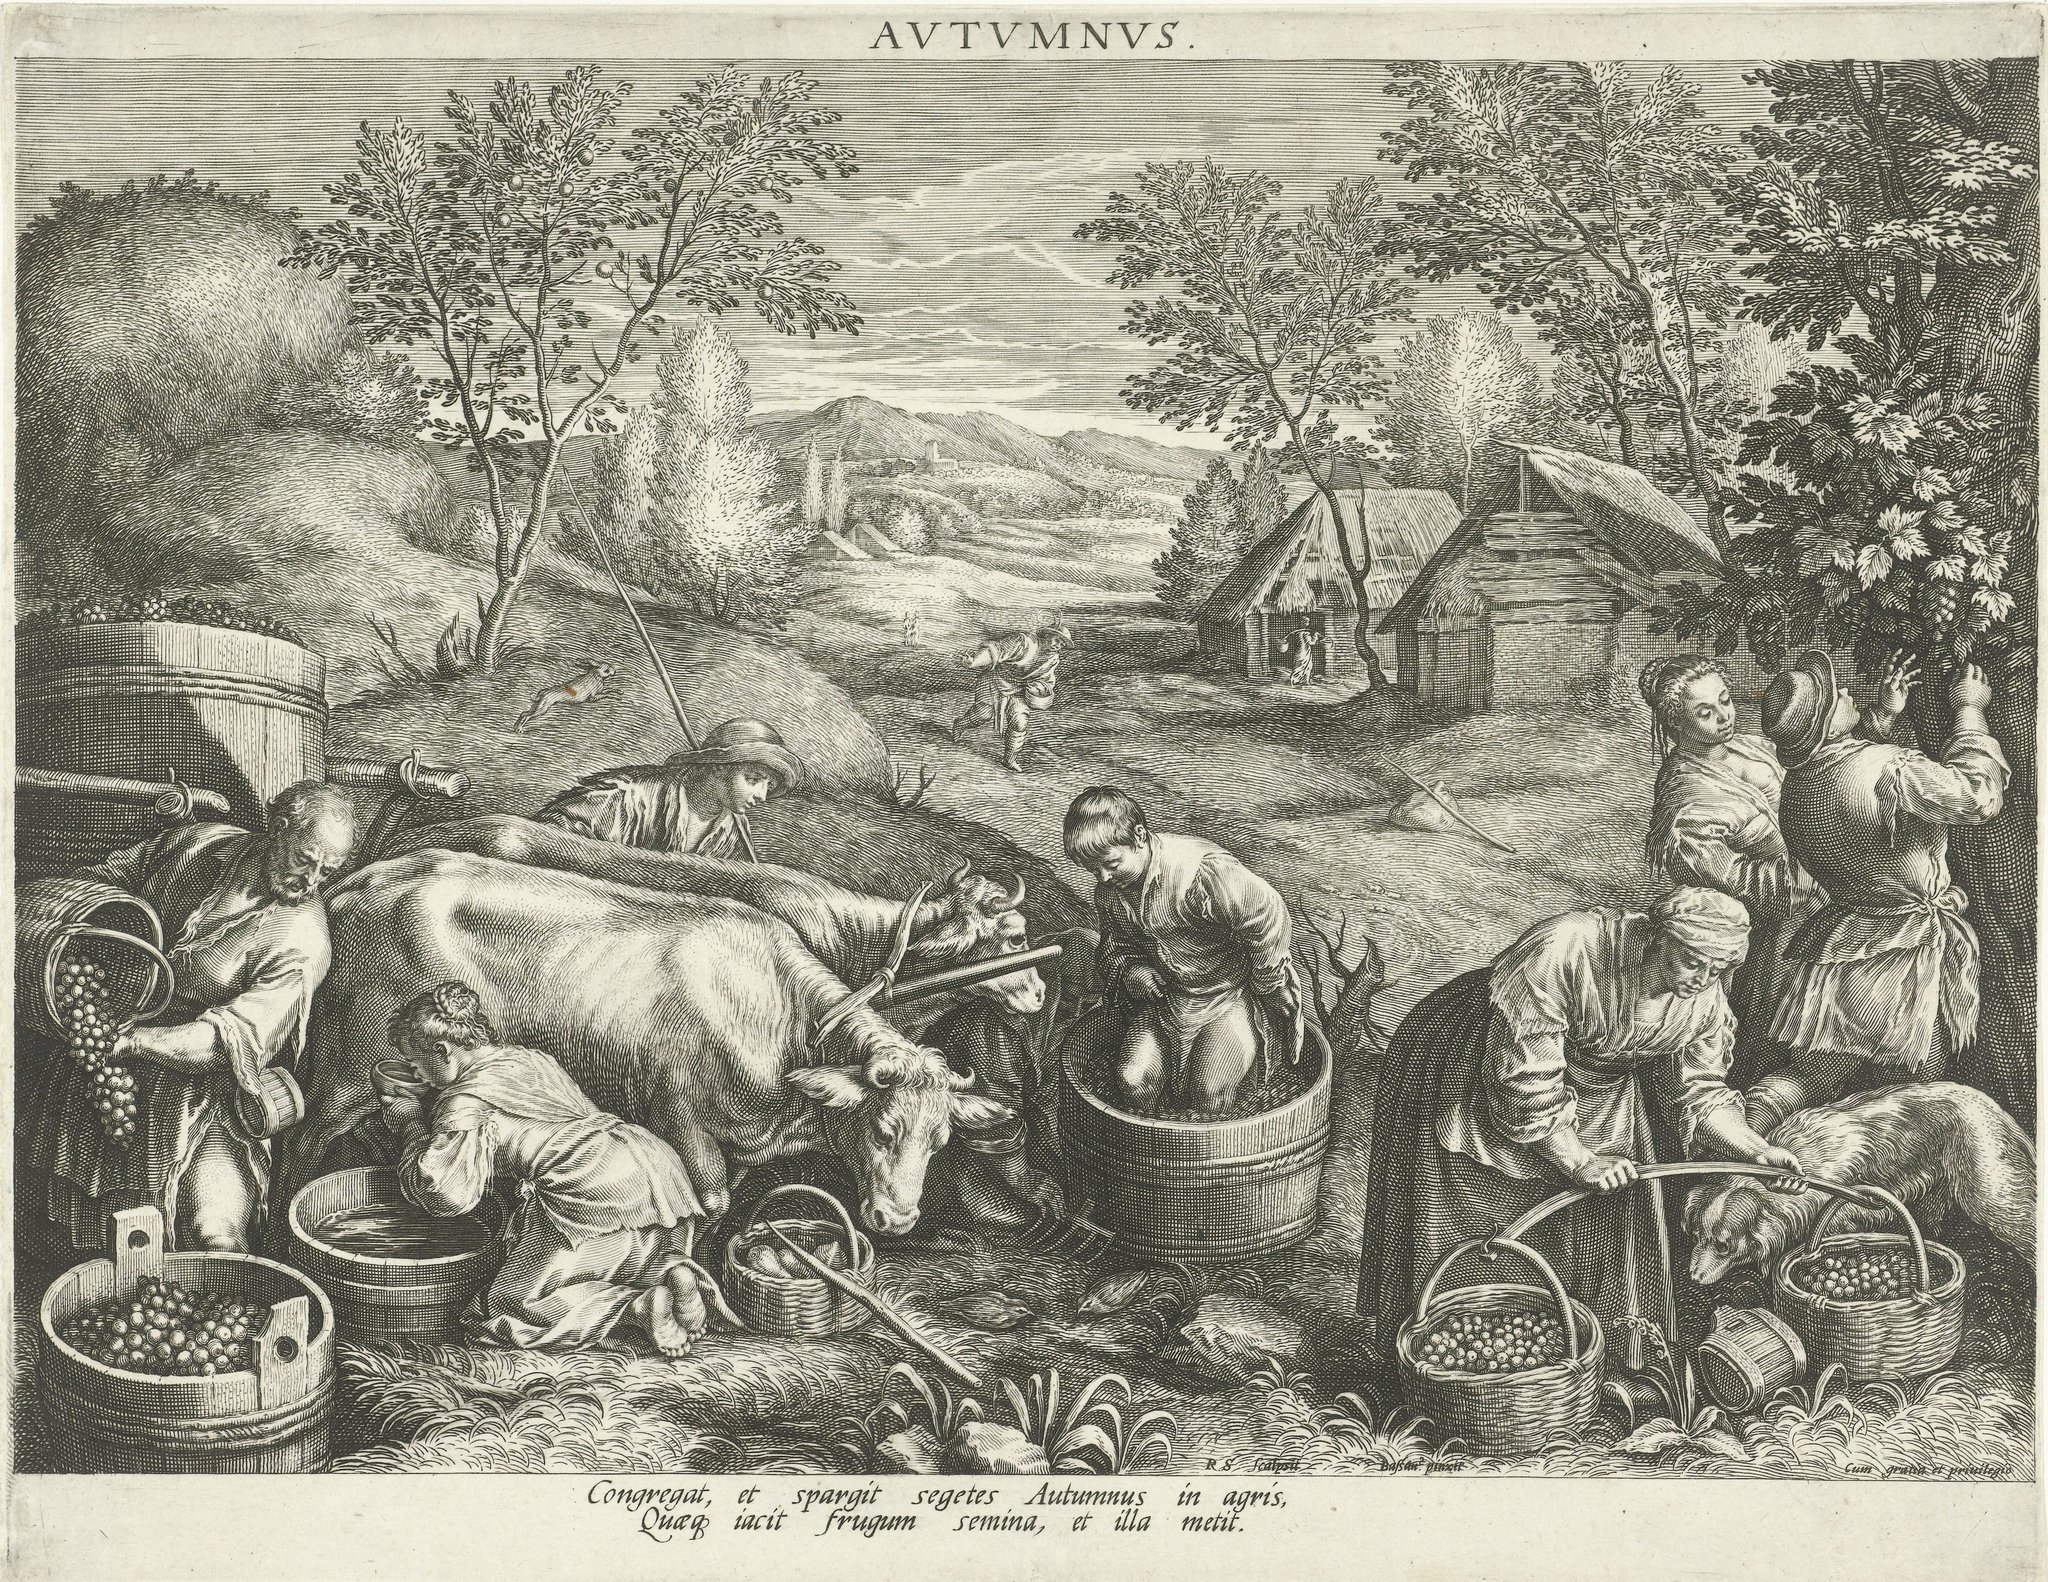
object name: print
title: Vier seizoenen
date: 1587-1595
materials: paper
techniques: engraving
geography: germany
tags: autumn ~ human activities (the four seasons of the year), treading grapes, autumn, fall, 'autumnus'; 'autunno' (ripa)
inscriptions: collector's mark: Lugt 240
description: Een herfstlandschap met herfstactiviteiten. Op de voorgrond druiven geplukt en geperst. De prent heeft een Latijns onderschrift en maakt deel uit van een vierdelige serie met als onderwerp de vier seizoenen.